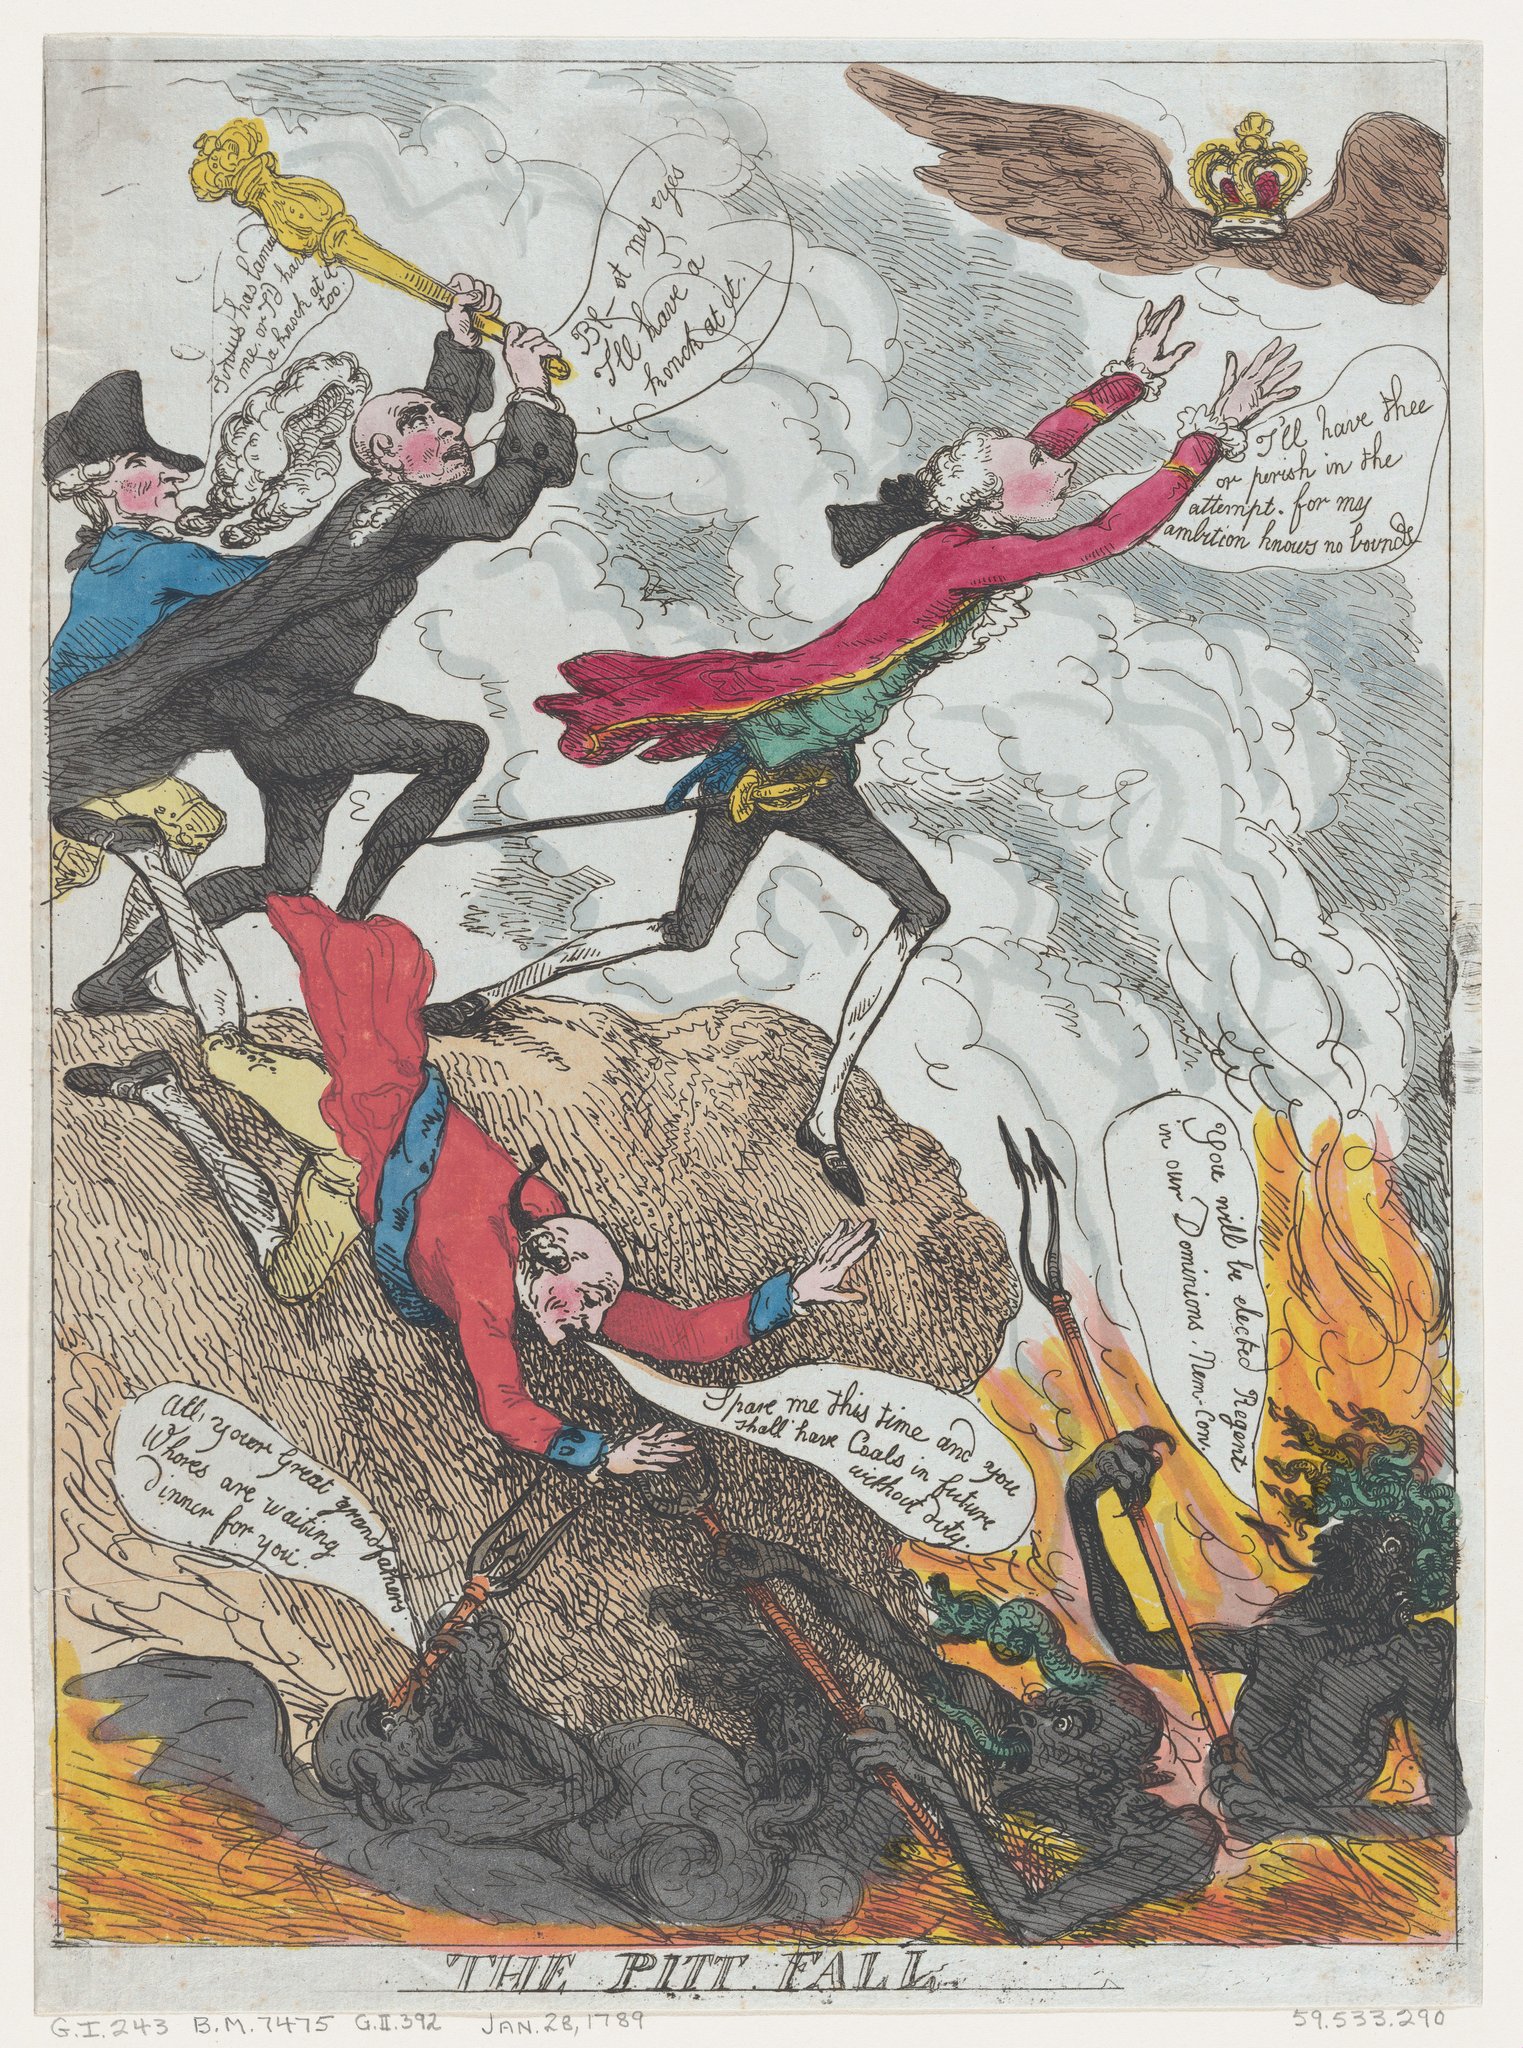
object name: print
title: The Pitt Fall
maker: frederick george byron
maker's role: artist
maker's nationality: british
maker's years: 1764-1792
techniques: aquatint, etching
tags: satire,men,demons